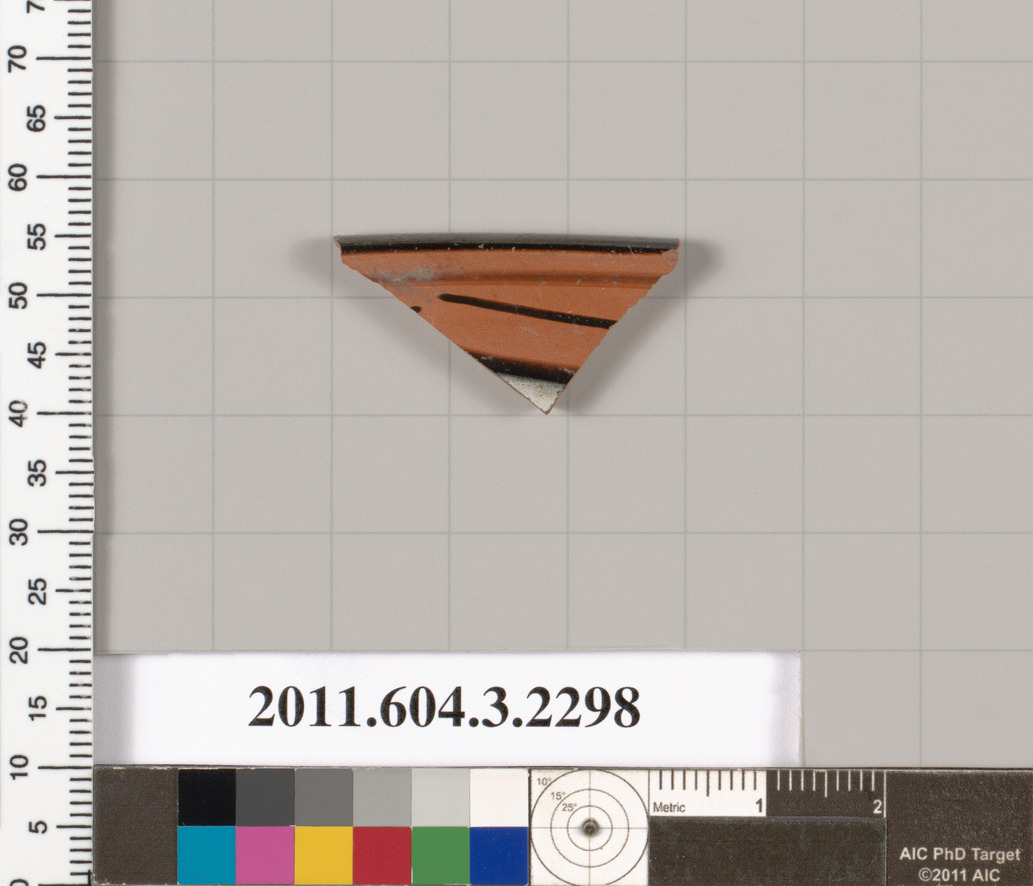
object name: kylix fragment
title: Terracotta rim fragment of a kylix: eye-cup (drinking cup)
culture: greek, attic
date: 530-500 BCE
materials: terracotta